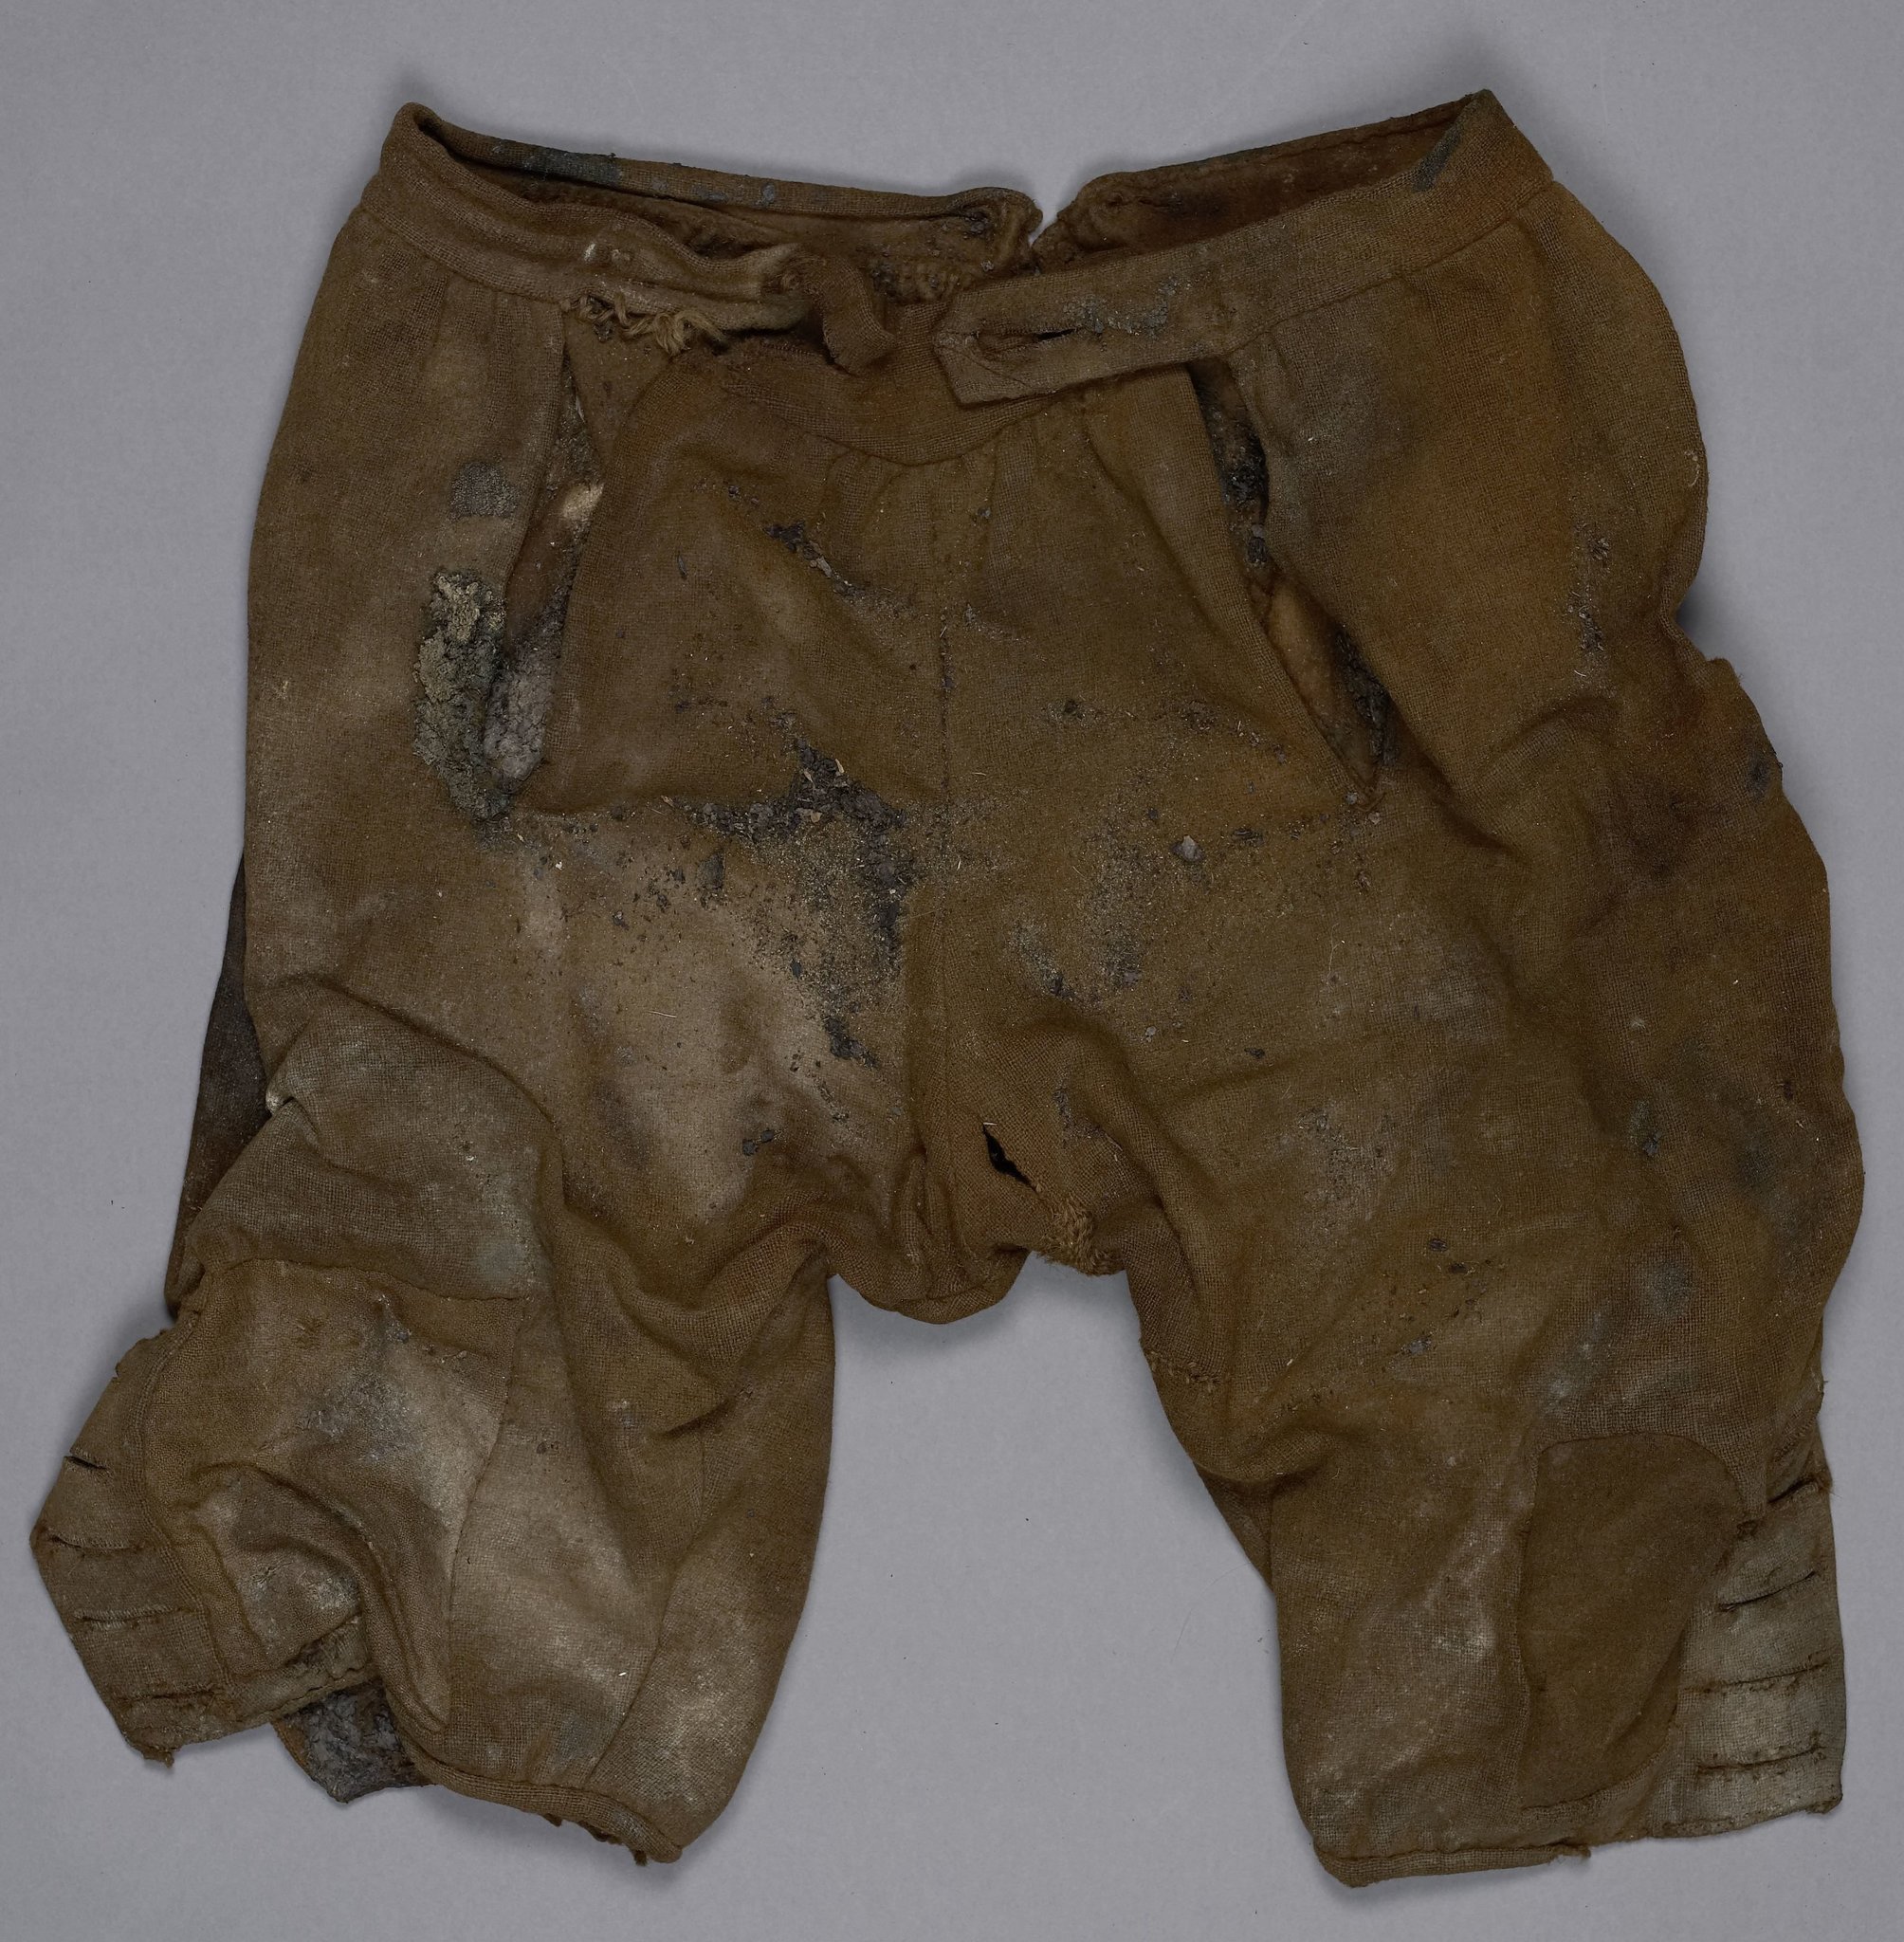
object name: breech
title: Kniebroek, bruin, met klepsluiting en twee steekzakken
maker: Anonymous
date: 1740-1760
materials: wool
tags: noordse compagnie, spitsbergen, zeeuwsche uytkyck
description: Kniebroek, bruin, met klepsluiting en twee steekzakken. Geweven in effen/platbinding met elf Z-getwiste kettingdraden en negen Z-getwiste inslagdraden per centimeter. Bijbehorend een ijzeren speld.